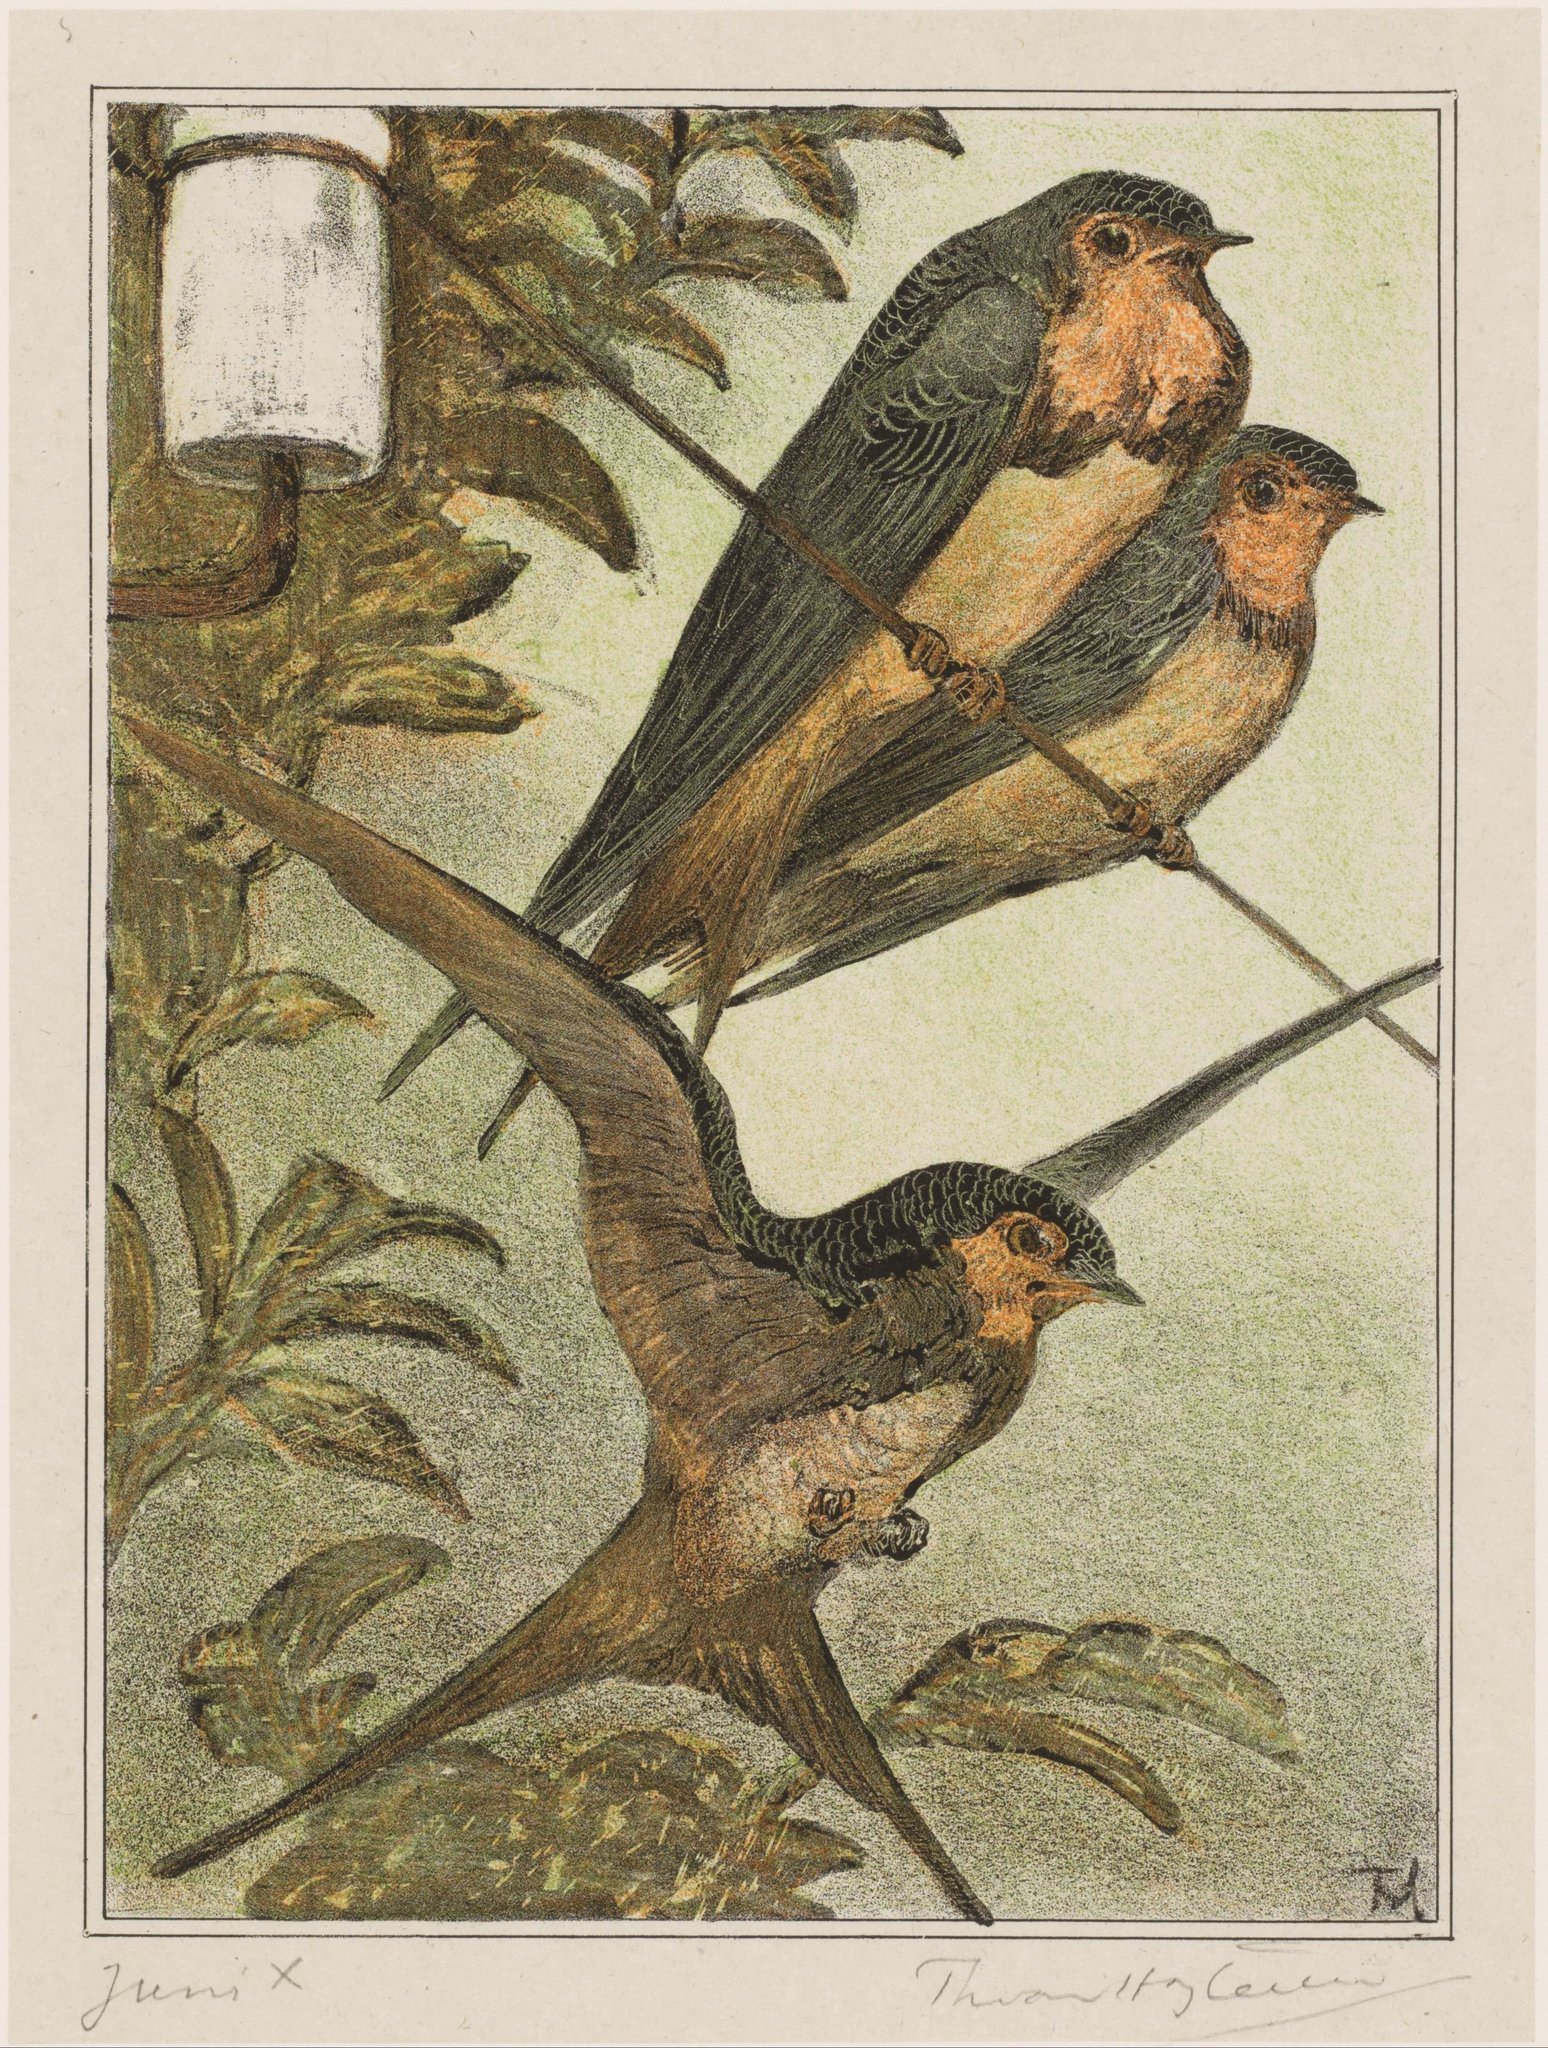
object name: print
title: Drie zwaluwen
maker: theo van hoytema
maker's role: draughtsman, painter, print maker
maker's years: 1863-1917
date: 1878-1910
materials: paper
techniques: lithograph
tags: song-birds: swallow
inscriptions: collector's mark: Lugt 2233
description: Twee zwaluwen zitten op een draad. Daaronder zweeft een zwaluw met de vleugels gespreid.